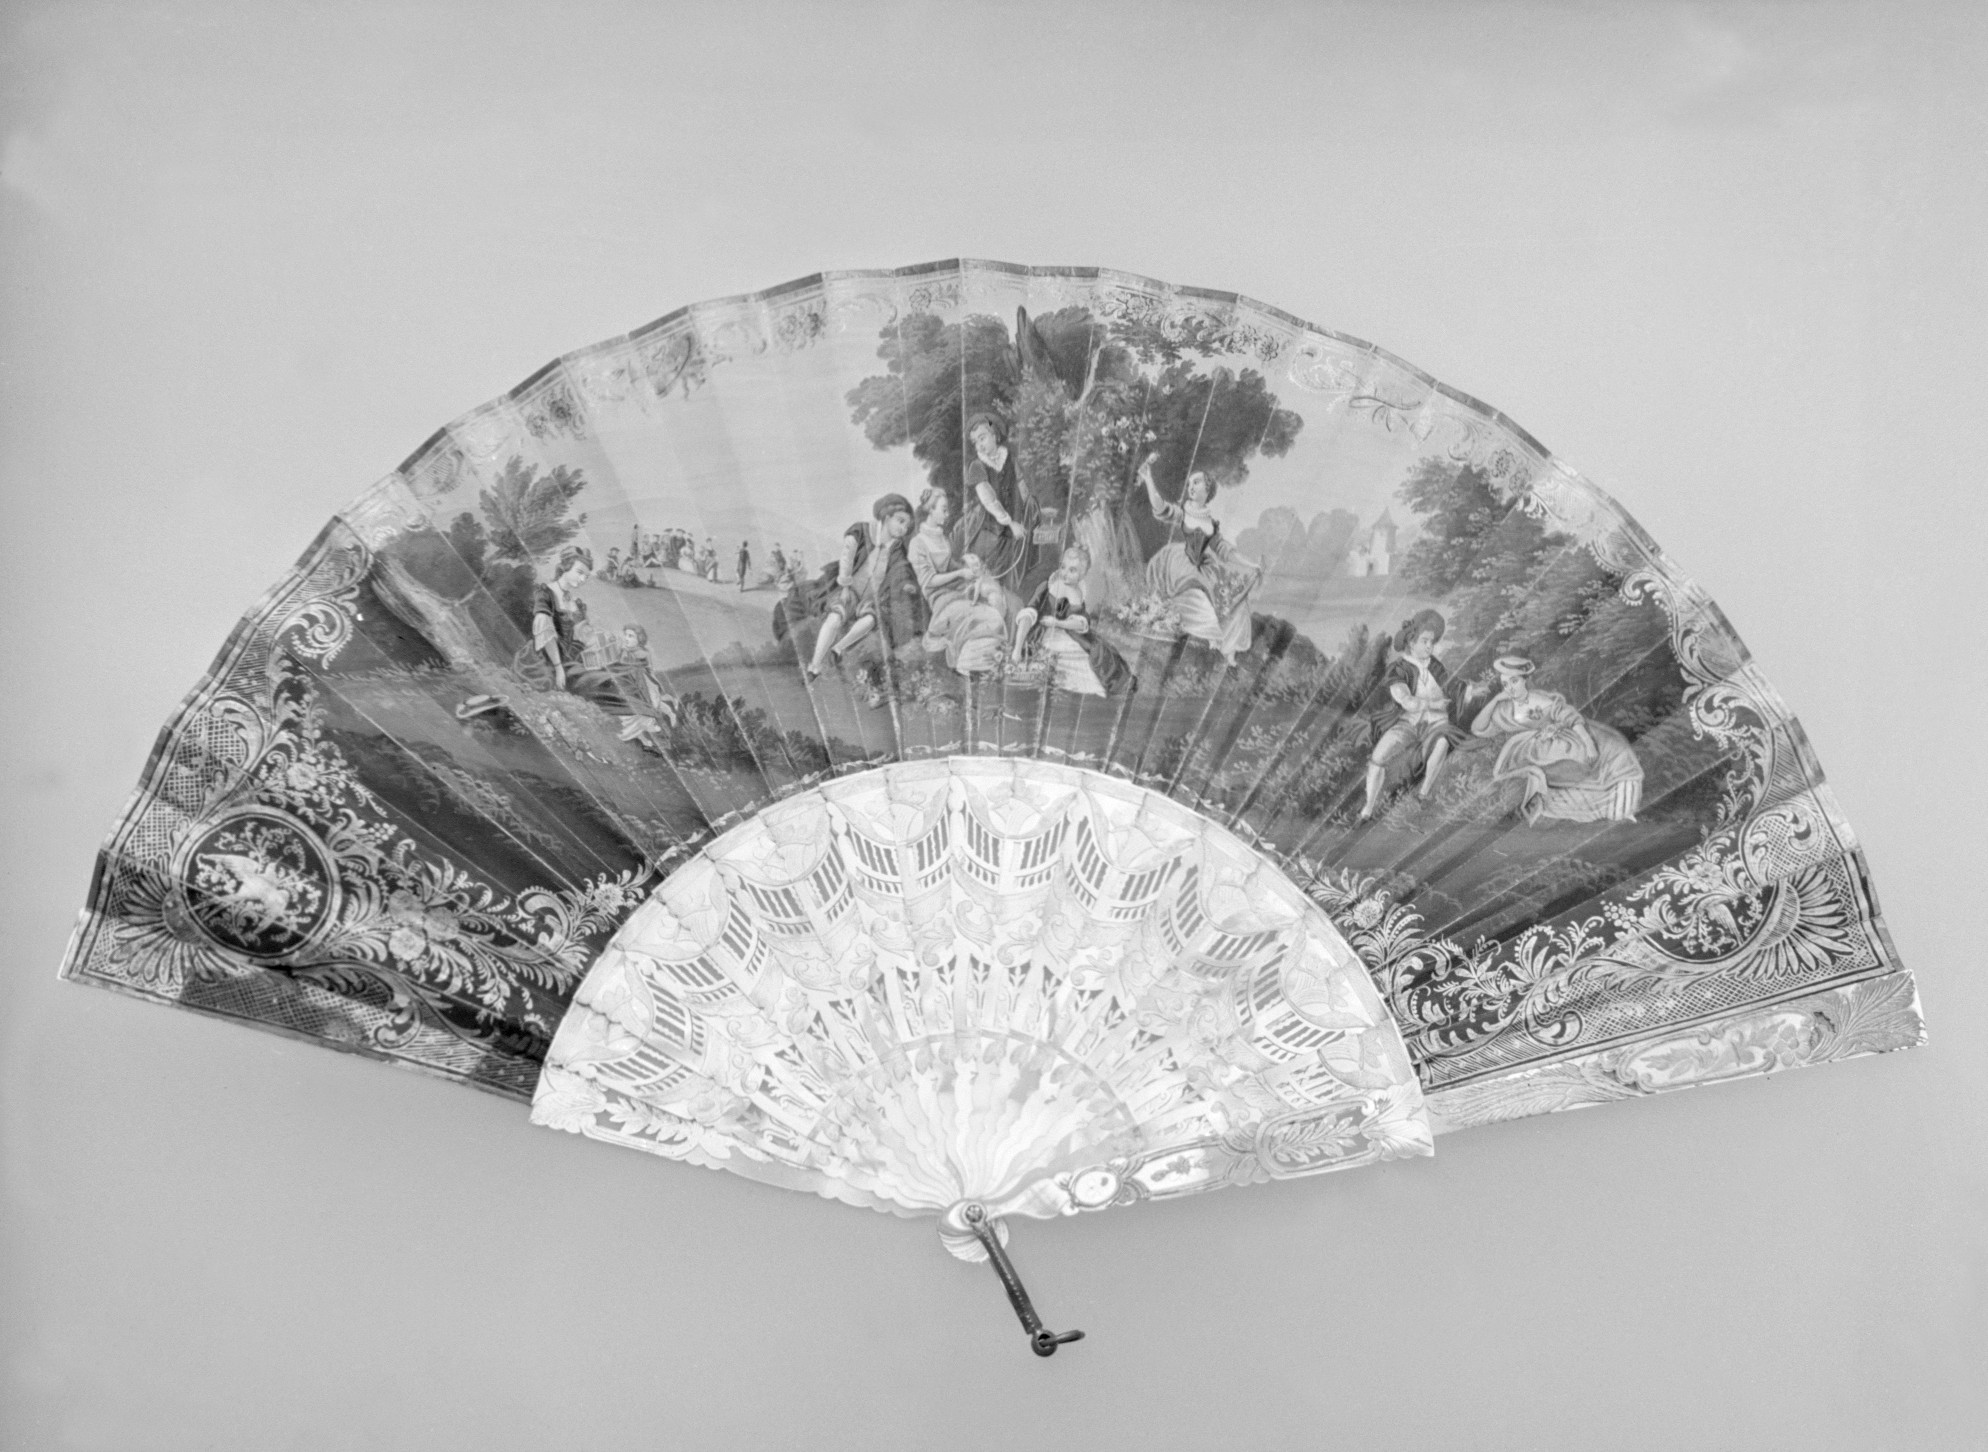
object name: fan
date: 1834-1866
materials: gold, metal, mother of pearl, parchment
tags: girls,men,women